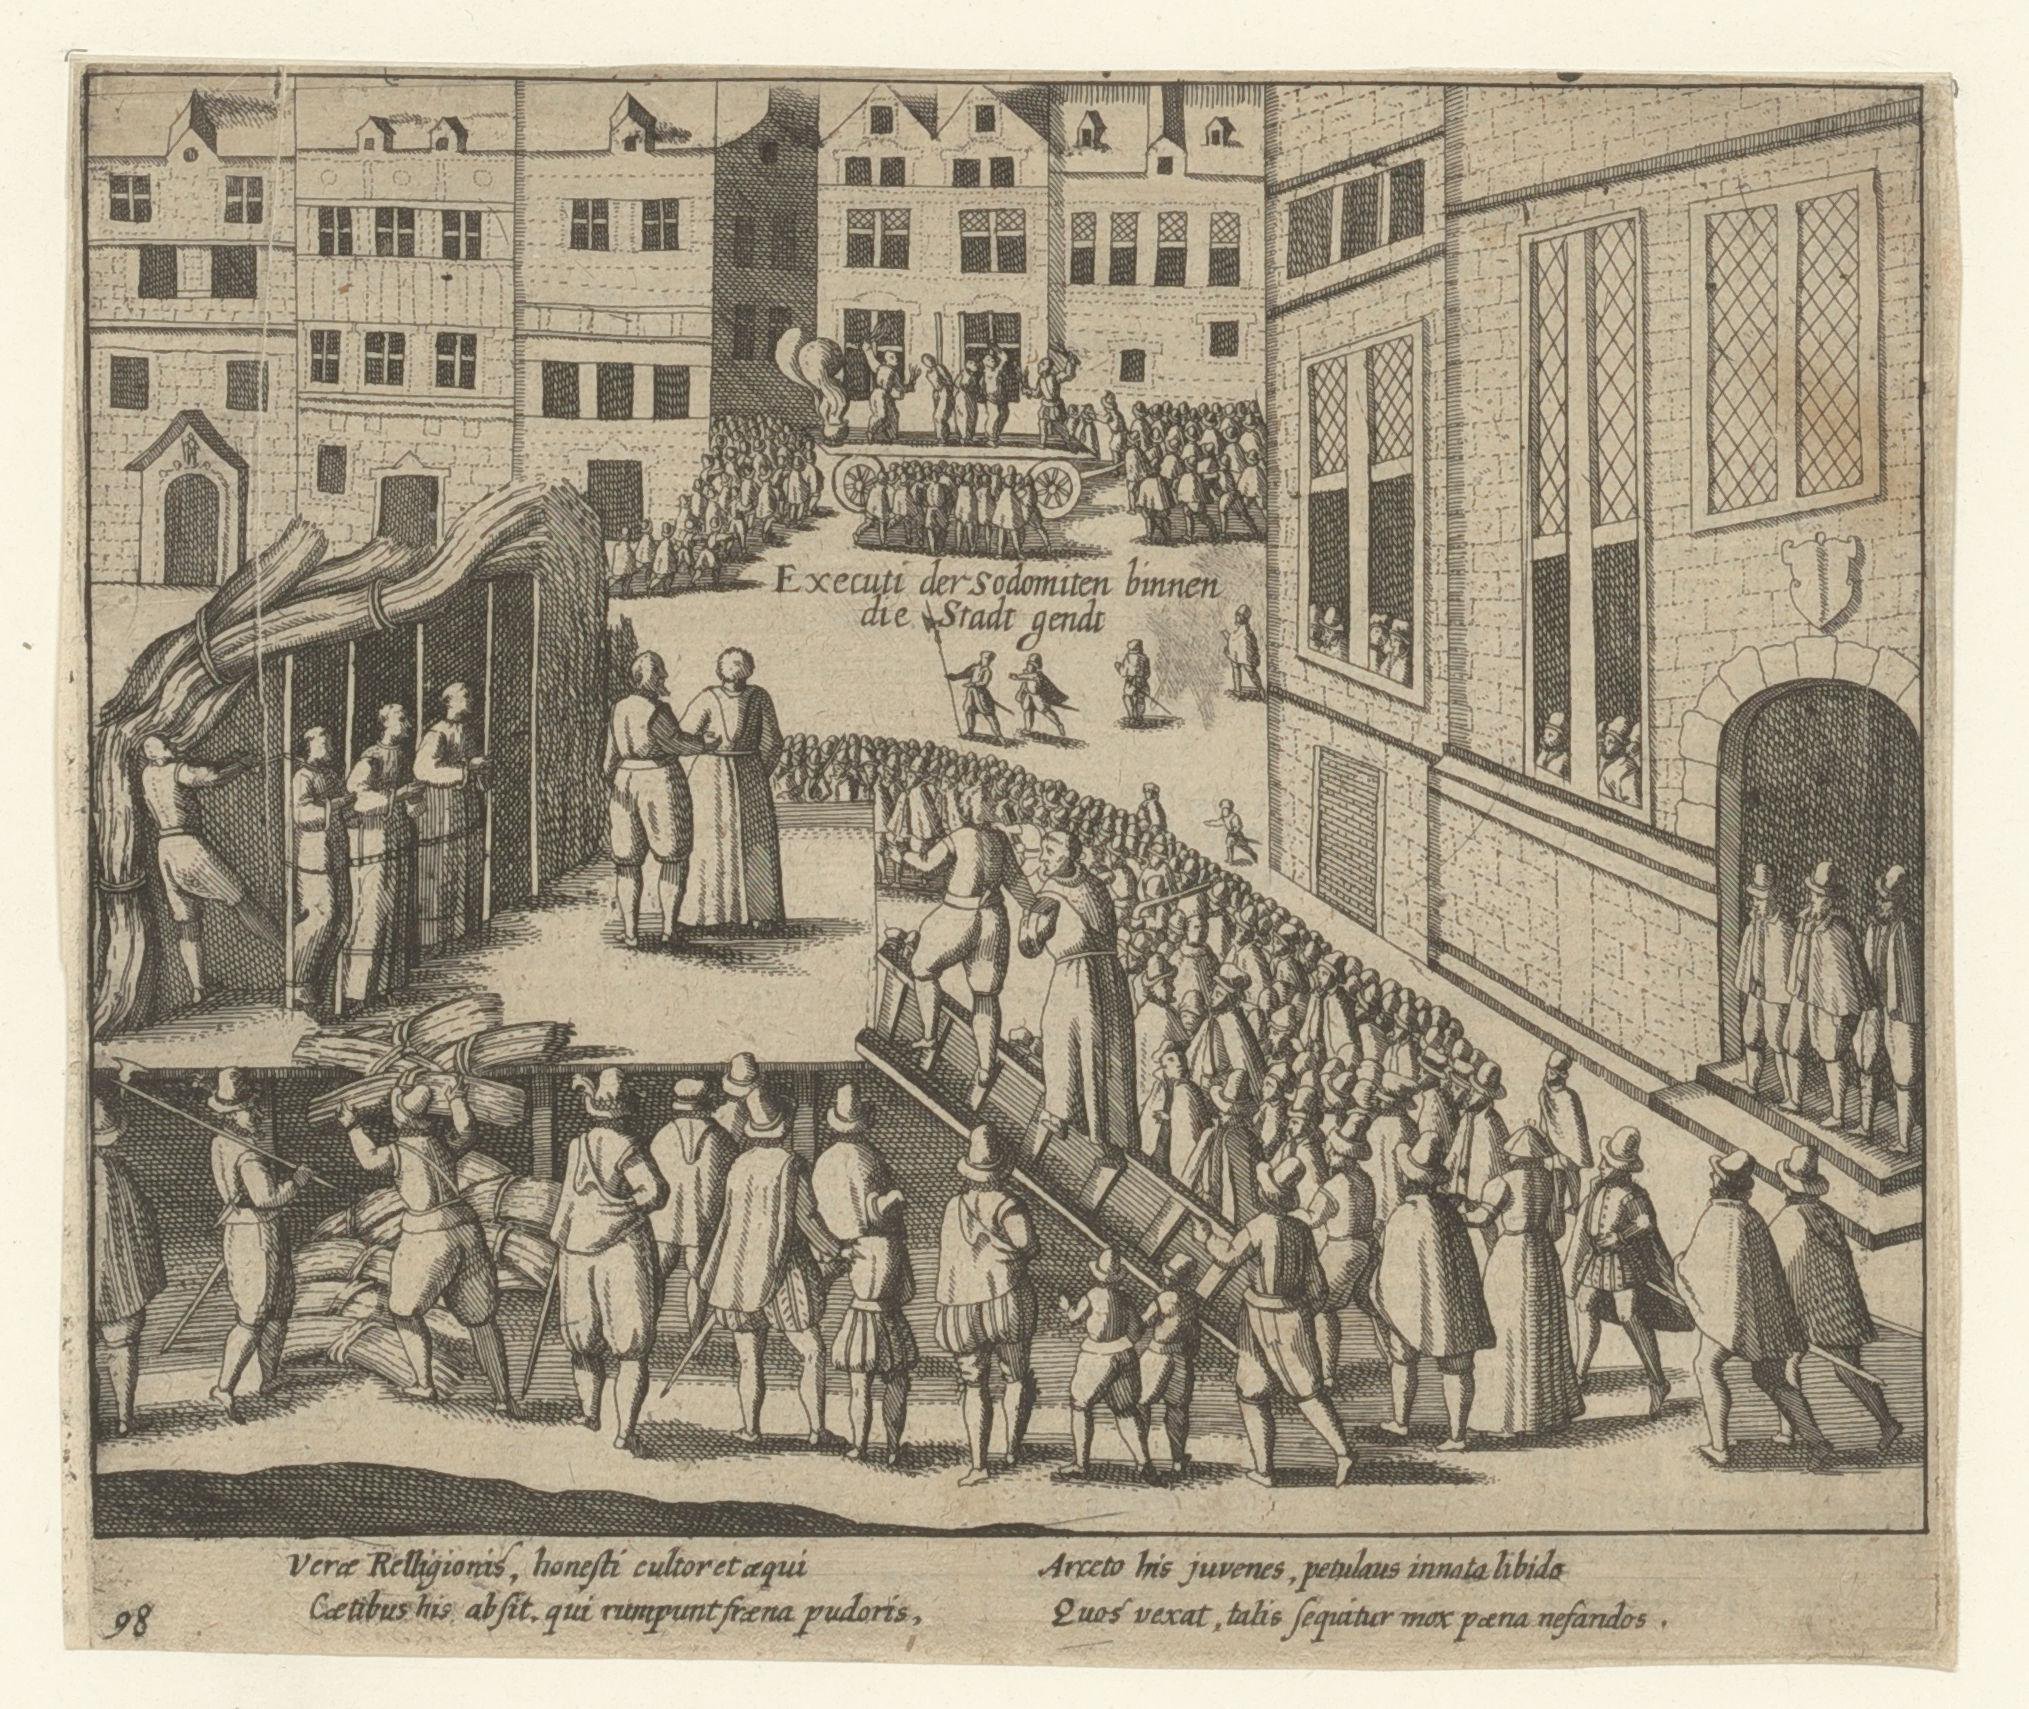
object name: print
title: Terechtstelling van monniken te Gent wegens sodomie, 1578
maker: Anonymous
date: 1616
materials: paper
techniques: etching, letterpress printing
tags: sodomy, sexual contact between men, law and jurisprudence, ghent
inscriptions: stamp, collector's mark: Lugt 1641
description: Geseling en terechtstelling van vier franciscaner monniken te Gent op beschuldiging van sodomie, 28 juni 1578. Op de achtergrond de geseling, op de voorgrond de monniken op de brandstapel. Onderaan een vierregelige tekst in Latijn. Linksonder genummerd: 98. Onderwerpsrubrieken binnen de Atlas Zeden en Gewoonten: Regeering, Rechtswezen.